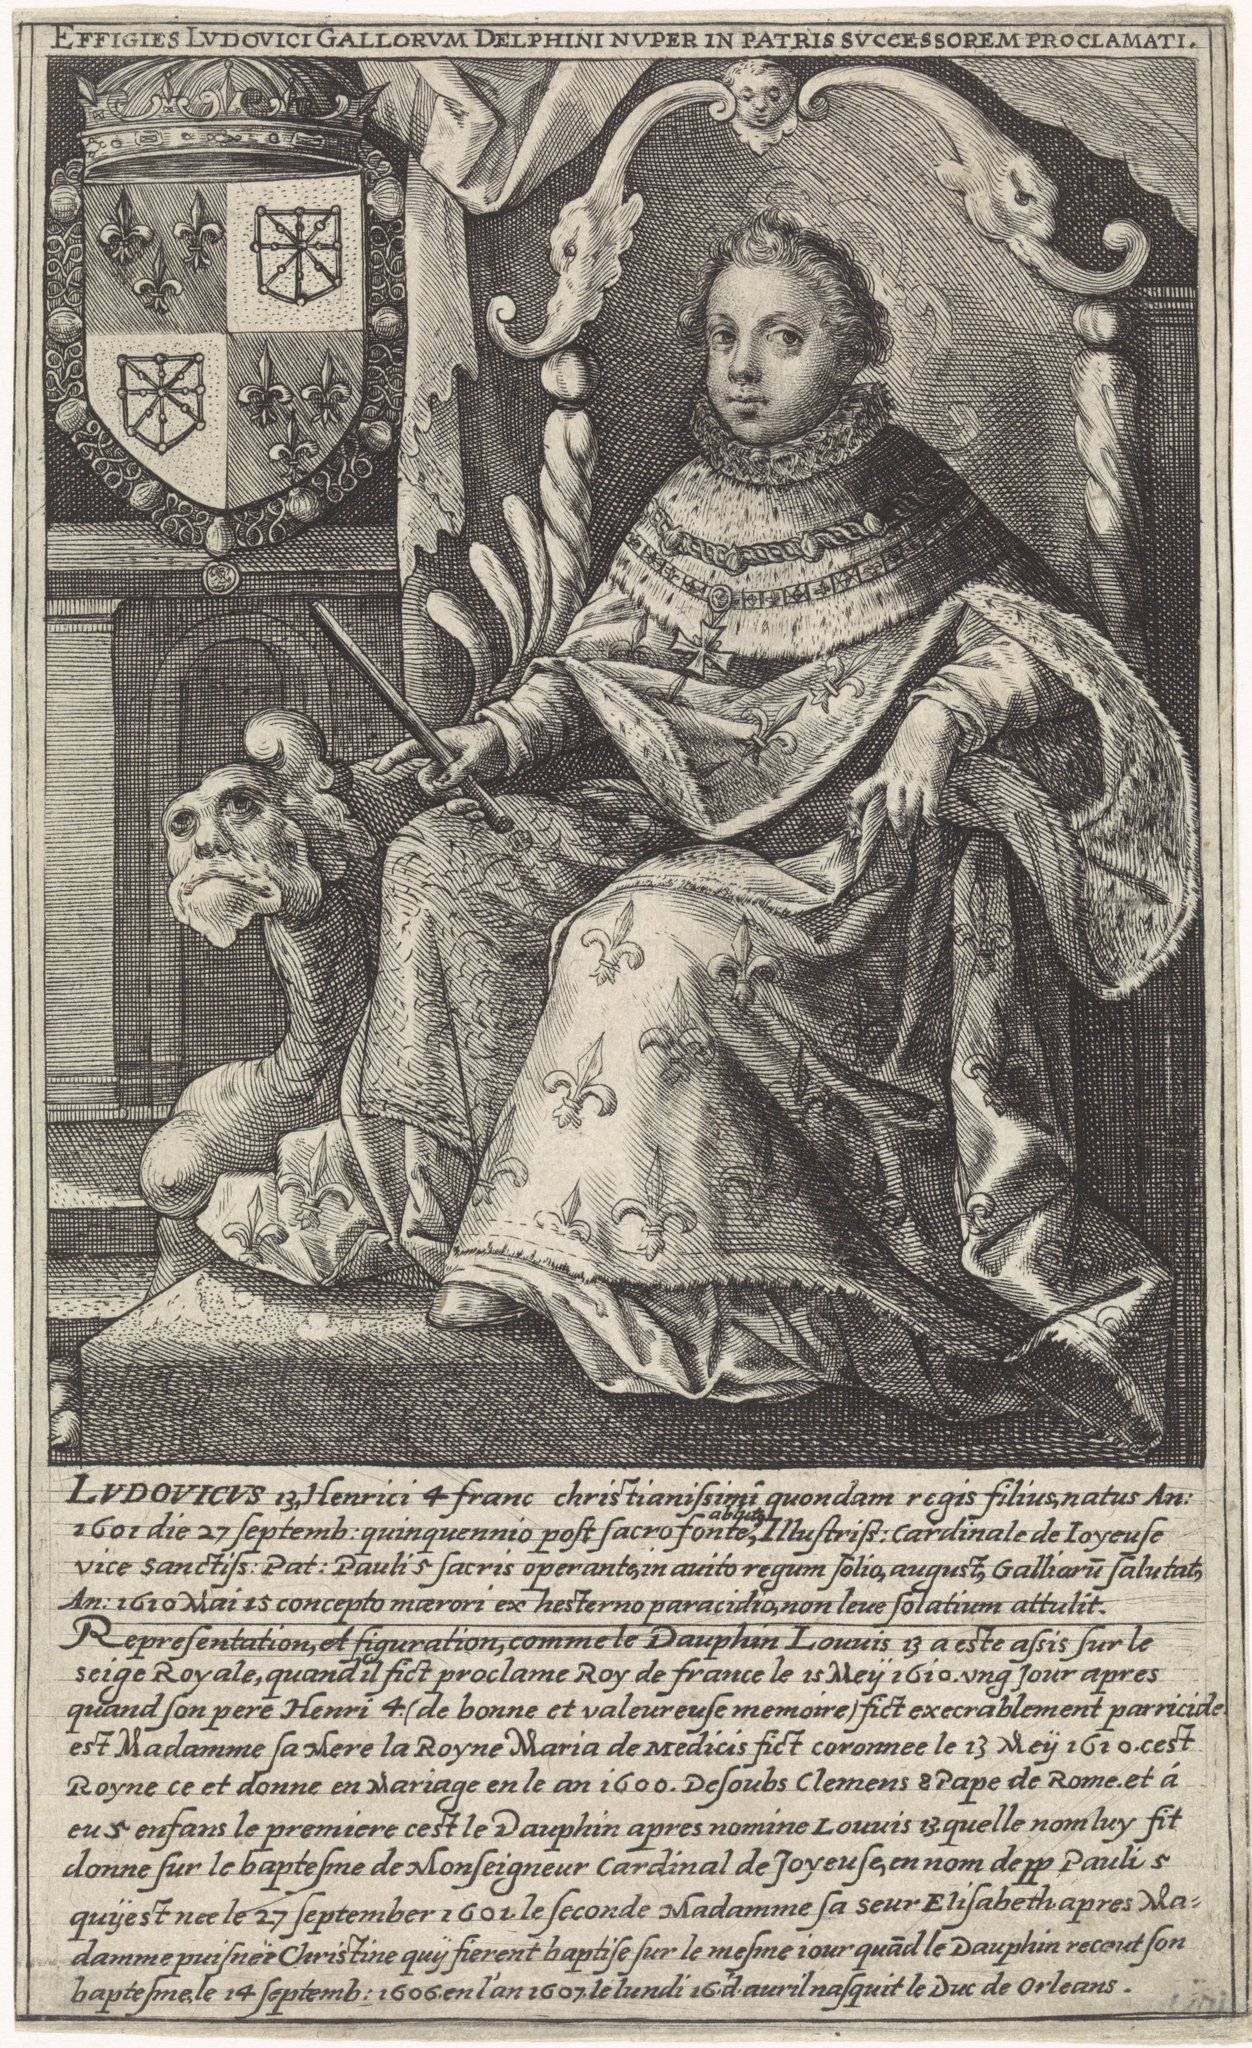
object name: print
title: Effigies Lvdovici Gallorvm Delphini Nvper in Patris Svccessorem Proclamati.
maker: crispijn van de passe (i)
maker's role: draughtsman, print maker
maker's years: 1564-1637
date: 1610-1637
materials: paper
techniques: engraving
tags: lodewijk xiii (koning van frankrijk), throne, knighthood order of the holy spirit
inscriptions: collector's mark: Lugt 2228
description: Portret van Lodewijk XIII, koning van Frankrijk. Hij zit op een troon en draagt een Ordeketting van de Orde van de Heilige Geest. Linksboven het wapenschild van de geportretteerde. In de marge een vierregelig onderschrift in het Latijn en een tienregelig onderschrift in het Frans over het leven van de prins tot aan het moment dat hij op 15 mei 1610, na de moord op zijn vader, tot koning werd benoemd. Pendant van een portret van Maria de' Medici.